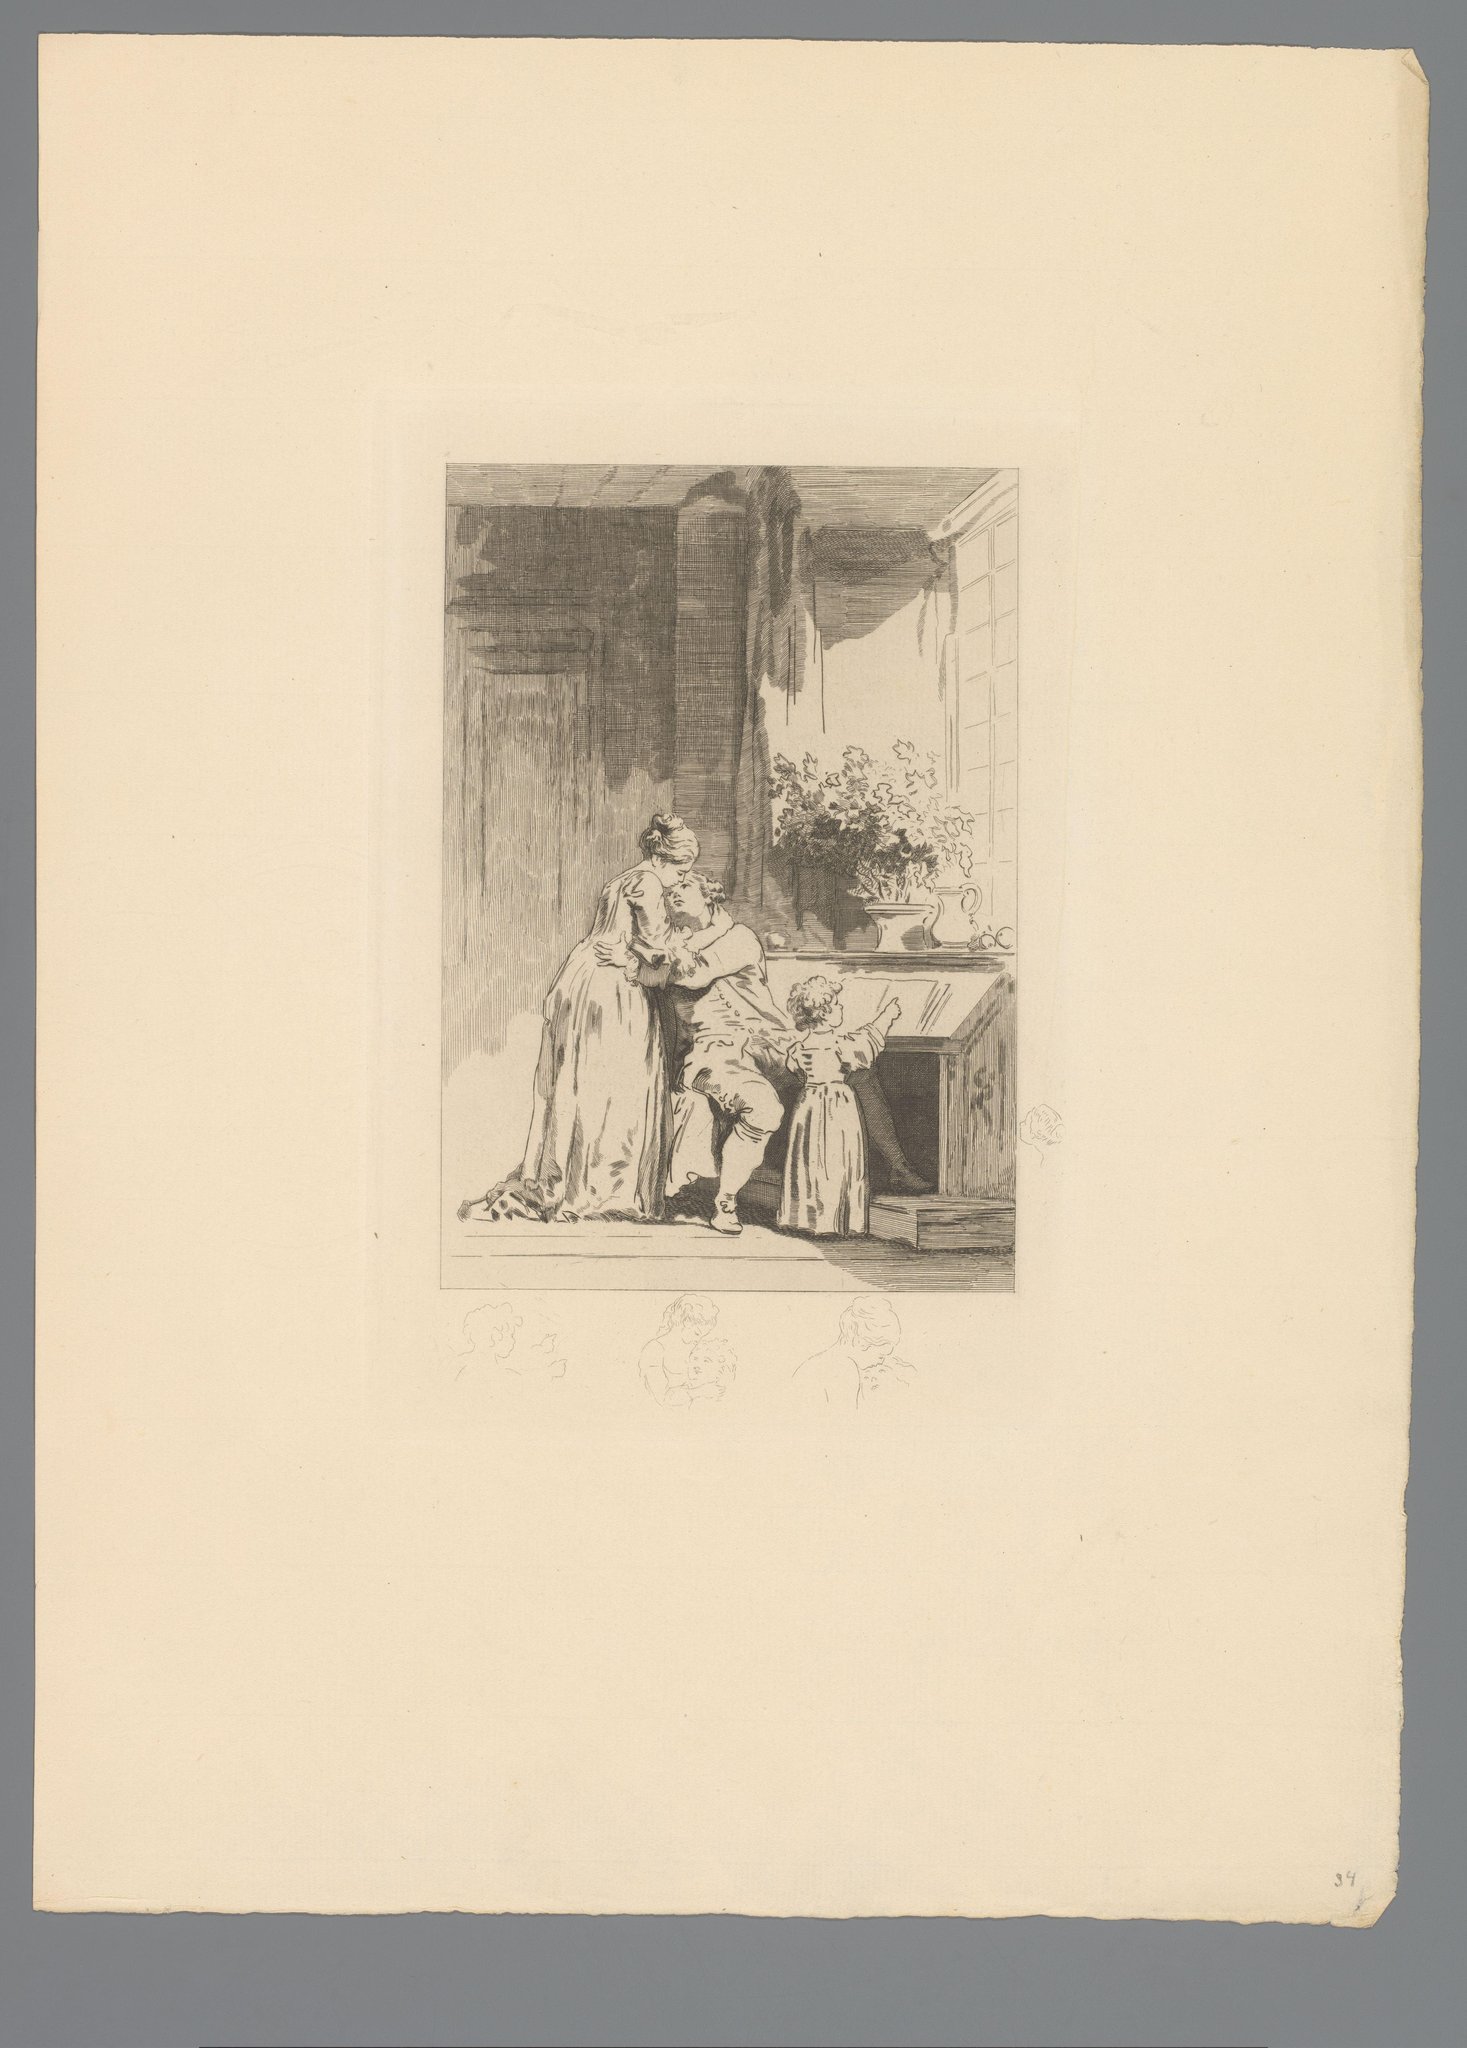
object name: photomechanical print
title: Figuren uit de verhalen van La Fontaine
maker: Anonymous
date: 1880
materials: paper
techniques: photoaquatint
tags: reading, (lovers) embracing each other, 'symplegma'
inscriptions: collector's mark:, collector's mark: Lugt 2228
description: Martial Potémont maakte etsen naar de tekeningen van Fragonard, die zich bevonden in een manuscript in de collectie van de verzamelaar Eugène Paillet. Rouquette bood hem aan de tekeningen zo exact mogelijk in prent te laten brengen door Martial Potémont: dit resulteerde in een serie van 57 etsen. Vervolgens werden deze gereproduceerd door middel van heliogravure. Deze omslag betreft een editie voor de letter, "Eau forte pure", de 1e staat van 3 waar men uit kon kiezen bij deze serie.